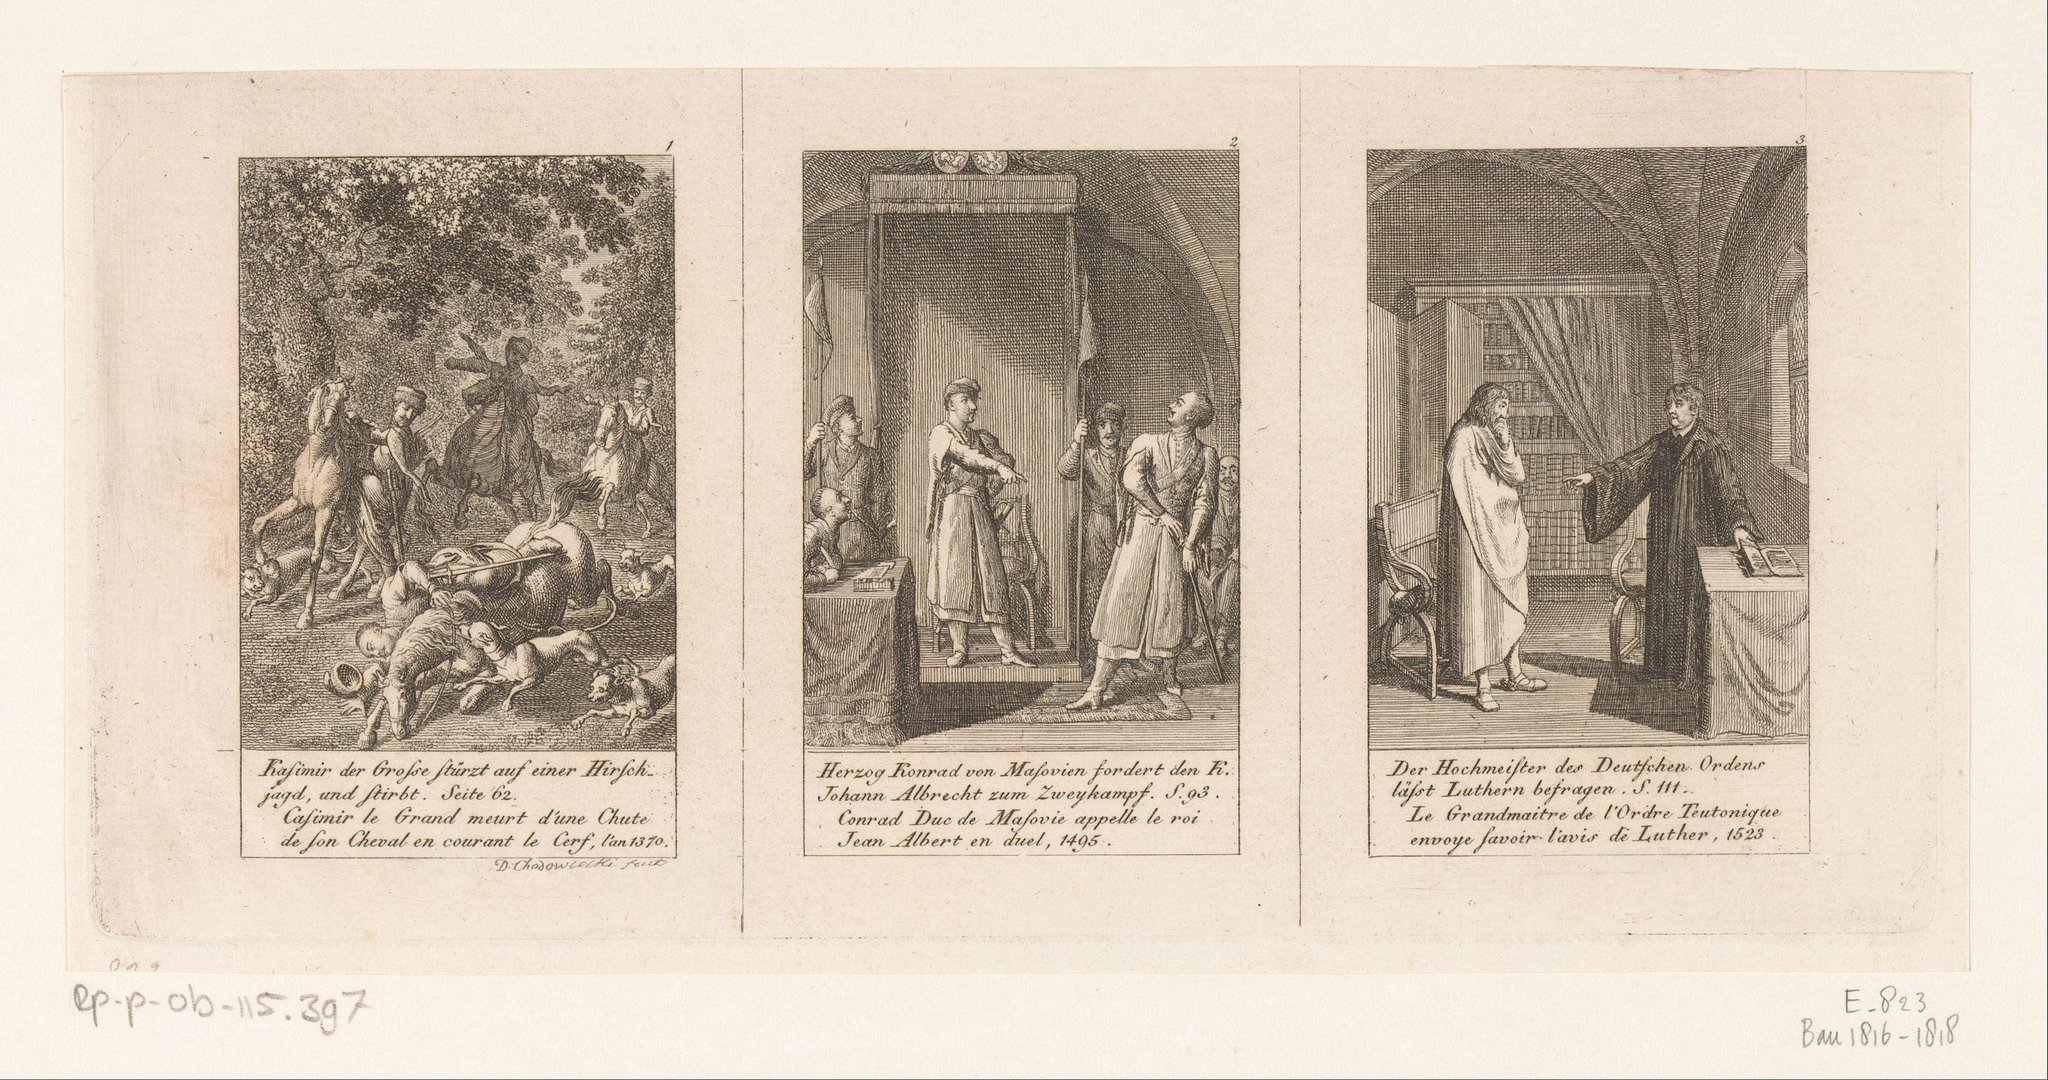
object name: print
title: Drie voorstellingen uit de geschiedenis van Polen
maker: daniel nikolaus chodowiecki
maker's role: draughtsman, print maker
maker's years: 1726-1801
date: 1796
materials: paper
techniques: etching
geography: berlin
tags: history, study; 'studiolo'; library, book, ruler, sovereign, index finger forwards, pointing, indicating, hunting accidents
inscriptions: collector's mark: Lugt 2228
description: Prent gebruikt voor: Historisch-genealogischen Kalender auf das Gemeinjahr 1797. Enthält die Geschichte von Polen (...). Berlijn: Johann Friedrich Unger, [1796].